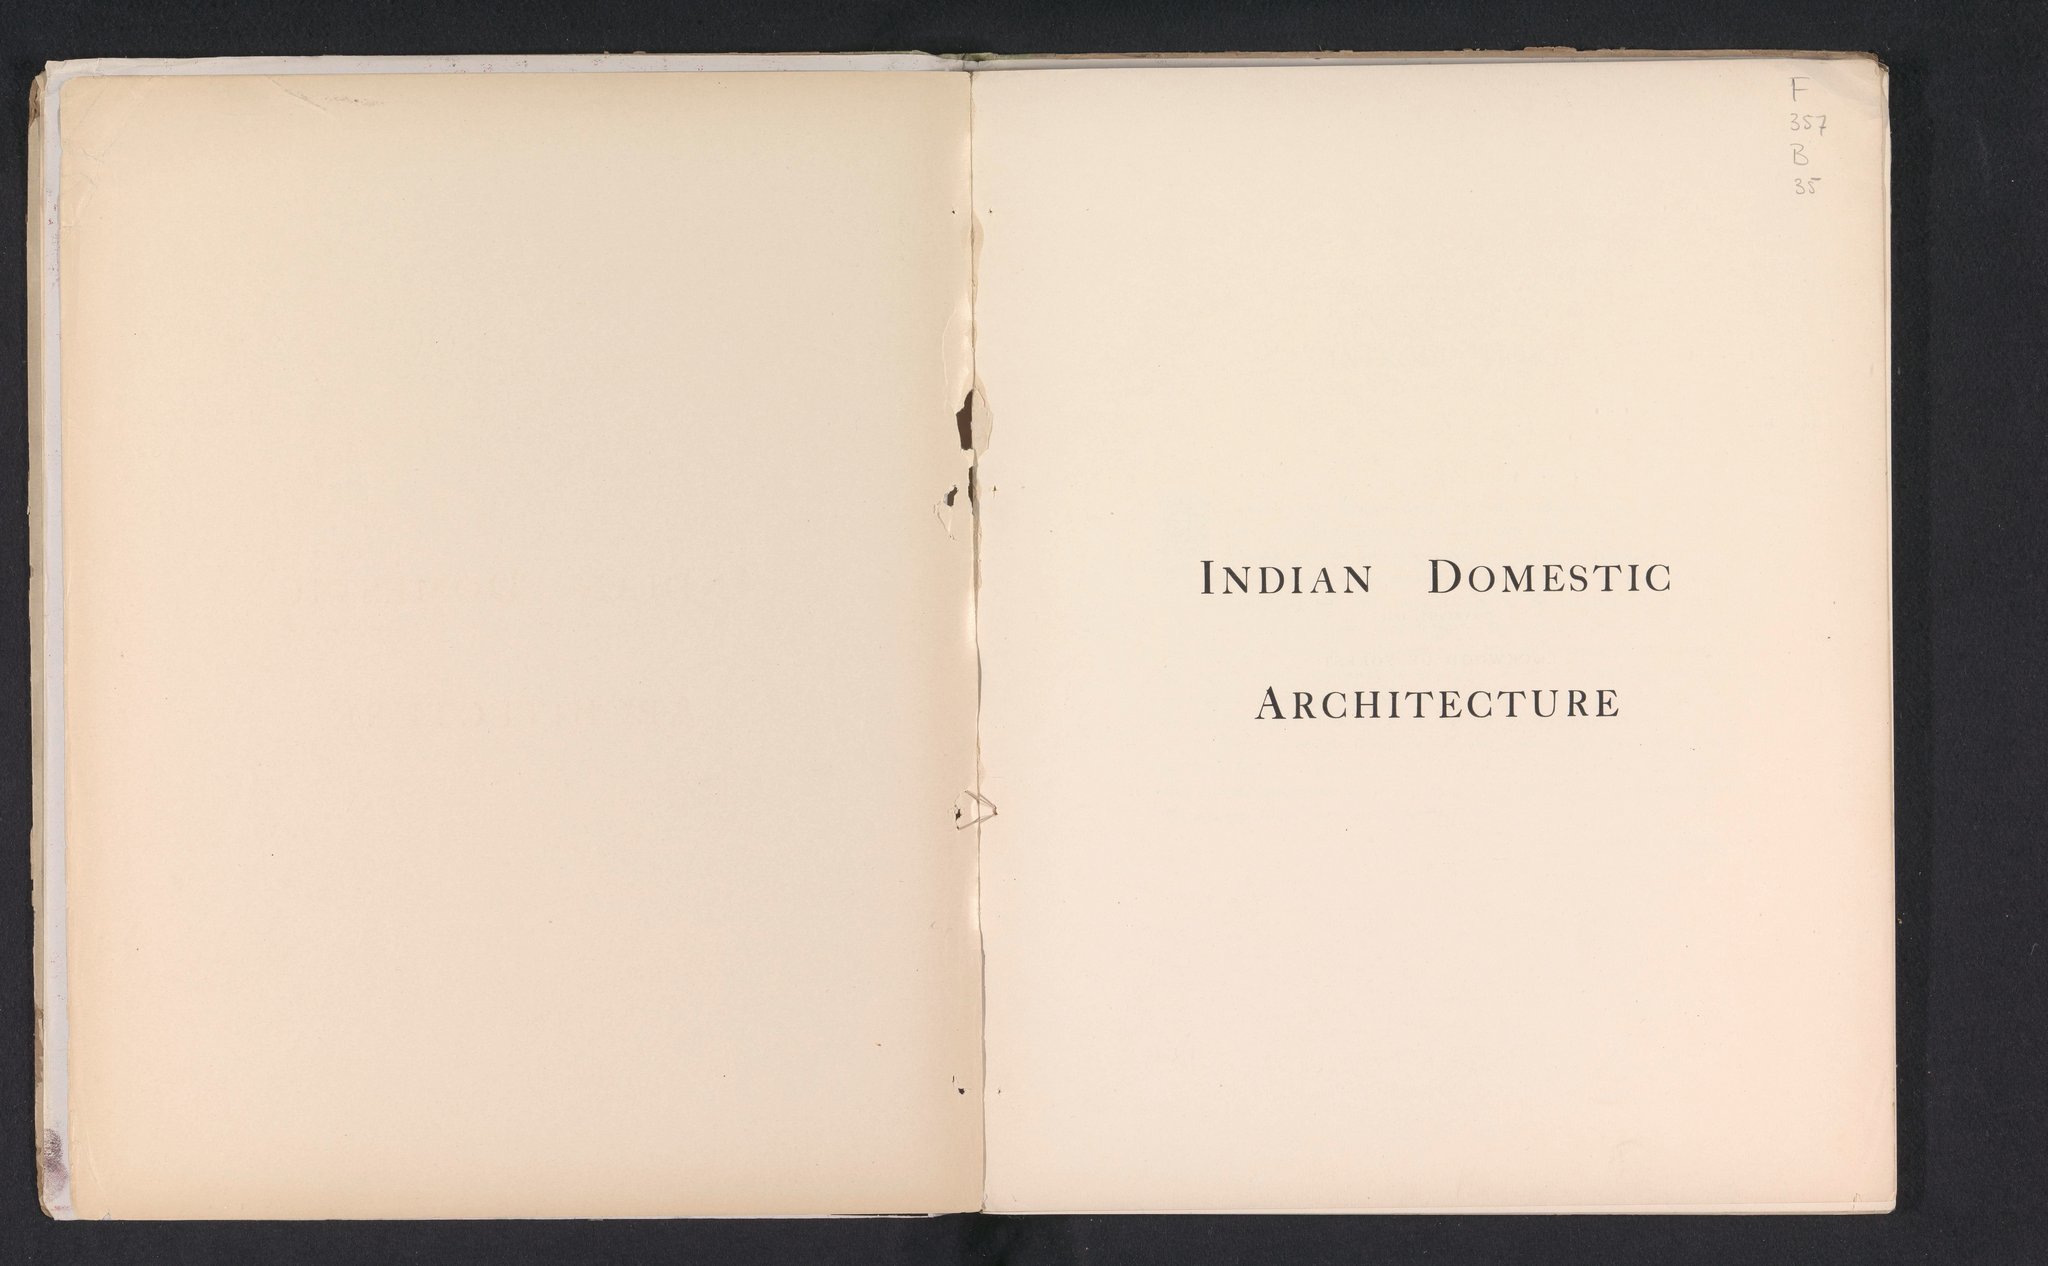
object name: book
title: Indian domestic architecture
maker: lockwood de forest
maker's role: painter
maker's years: 1850-1932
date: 1885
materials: cardboard, paper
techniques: marbling, photoaquatint, printing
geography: boston